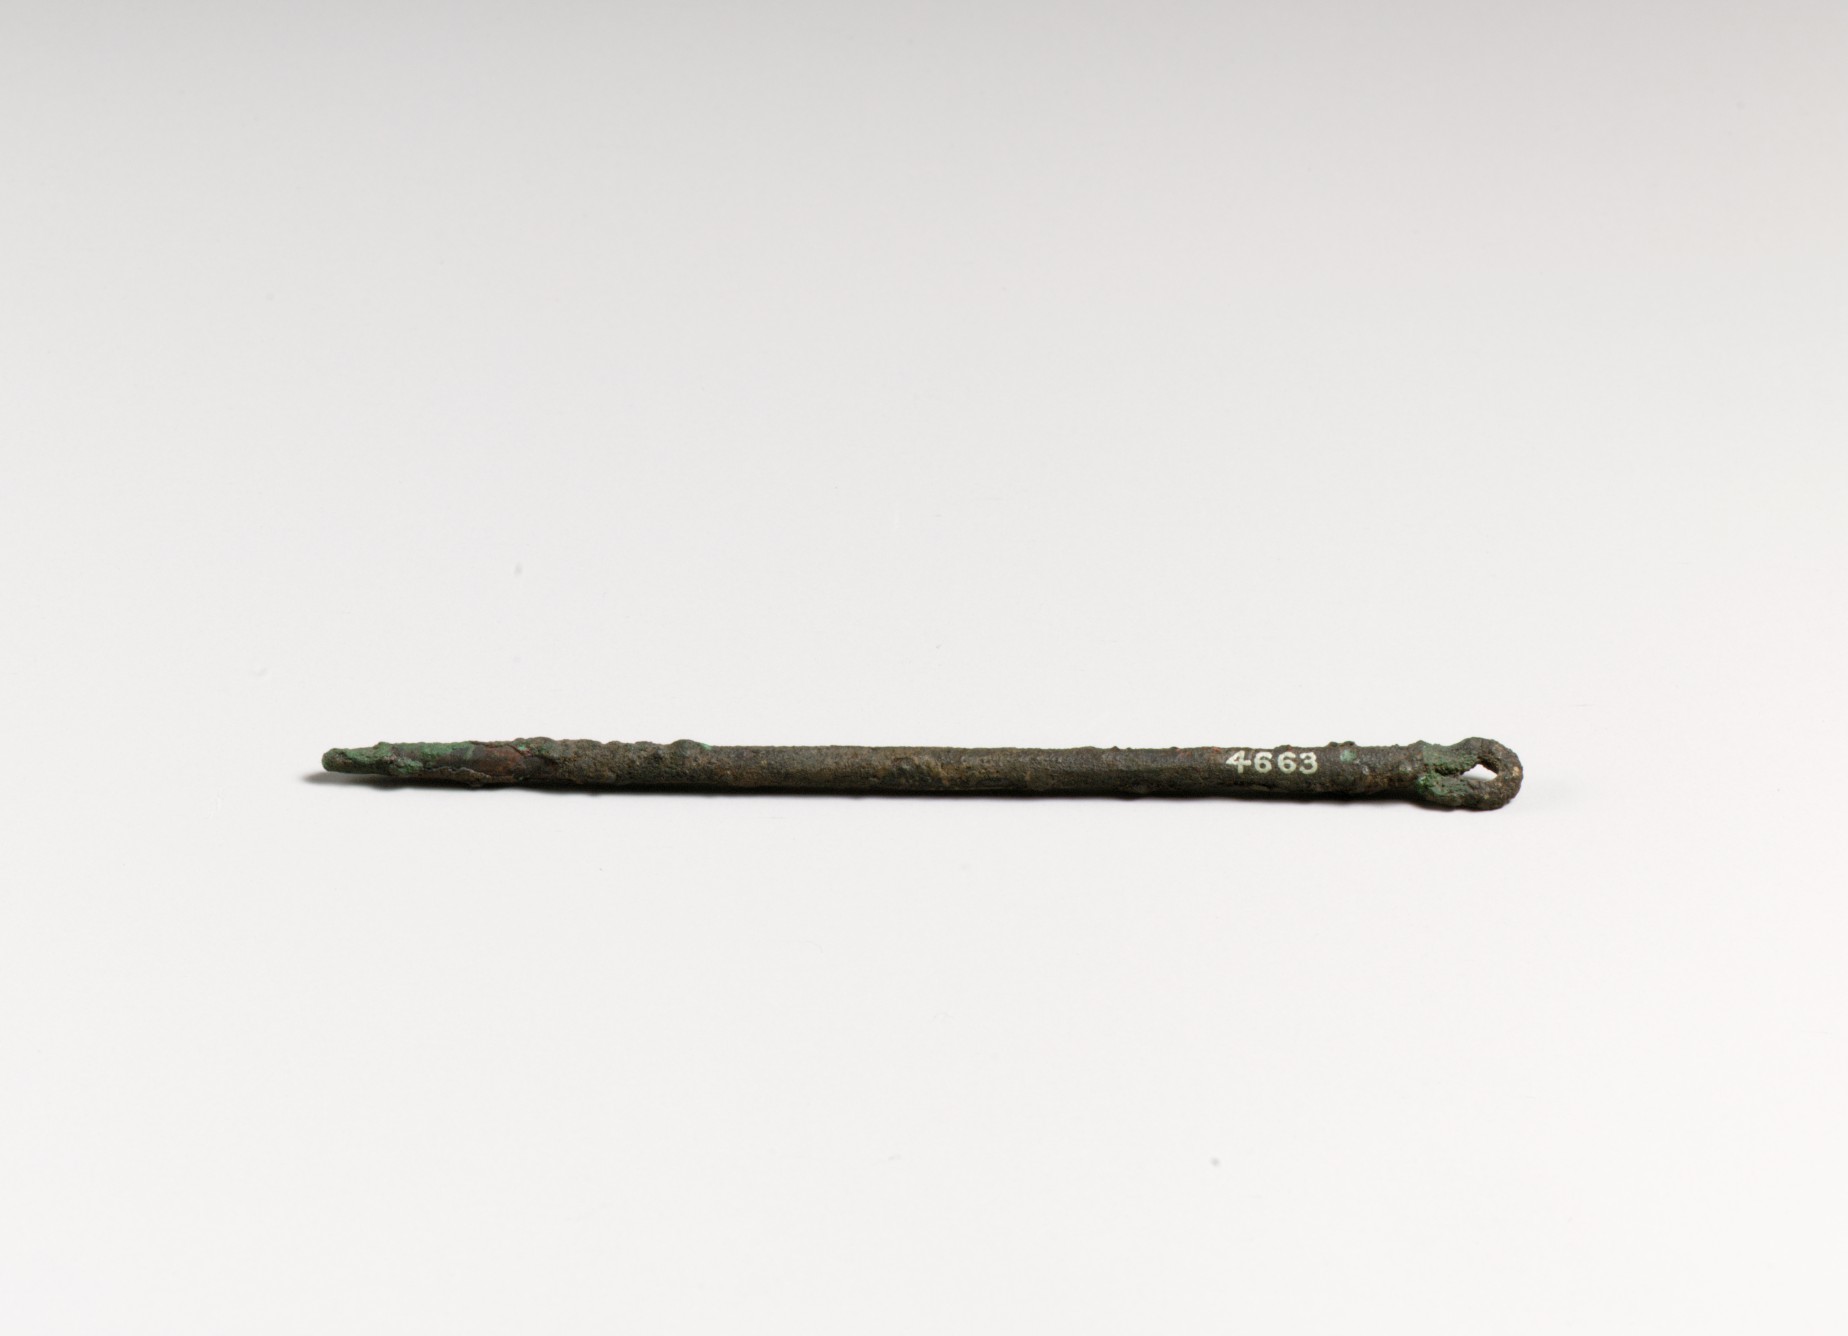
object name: needle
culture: cypriot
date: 3900 BCE-100 CE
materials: bronze